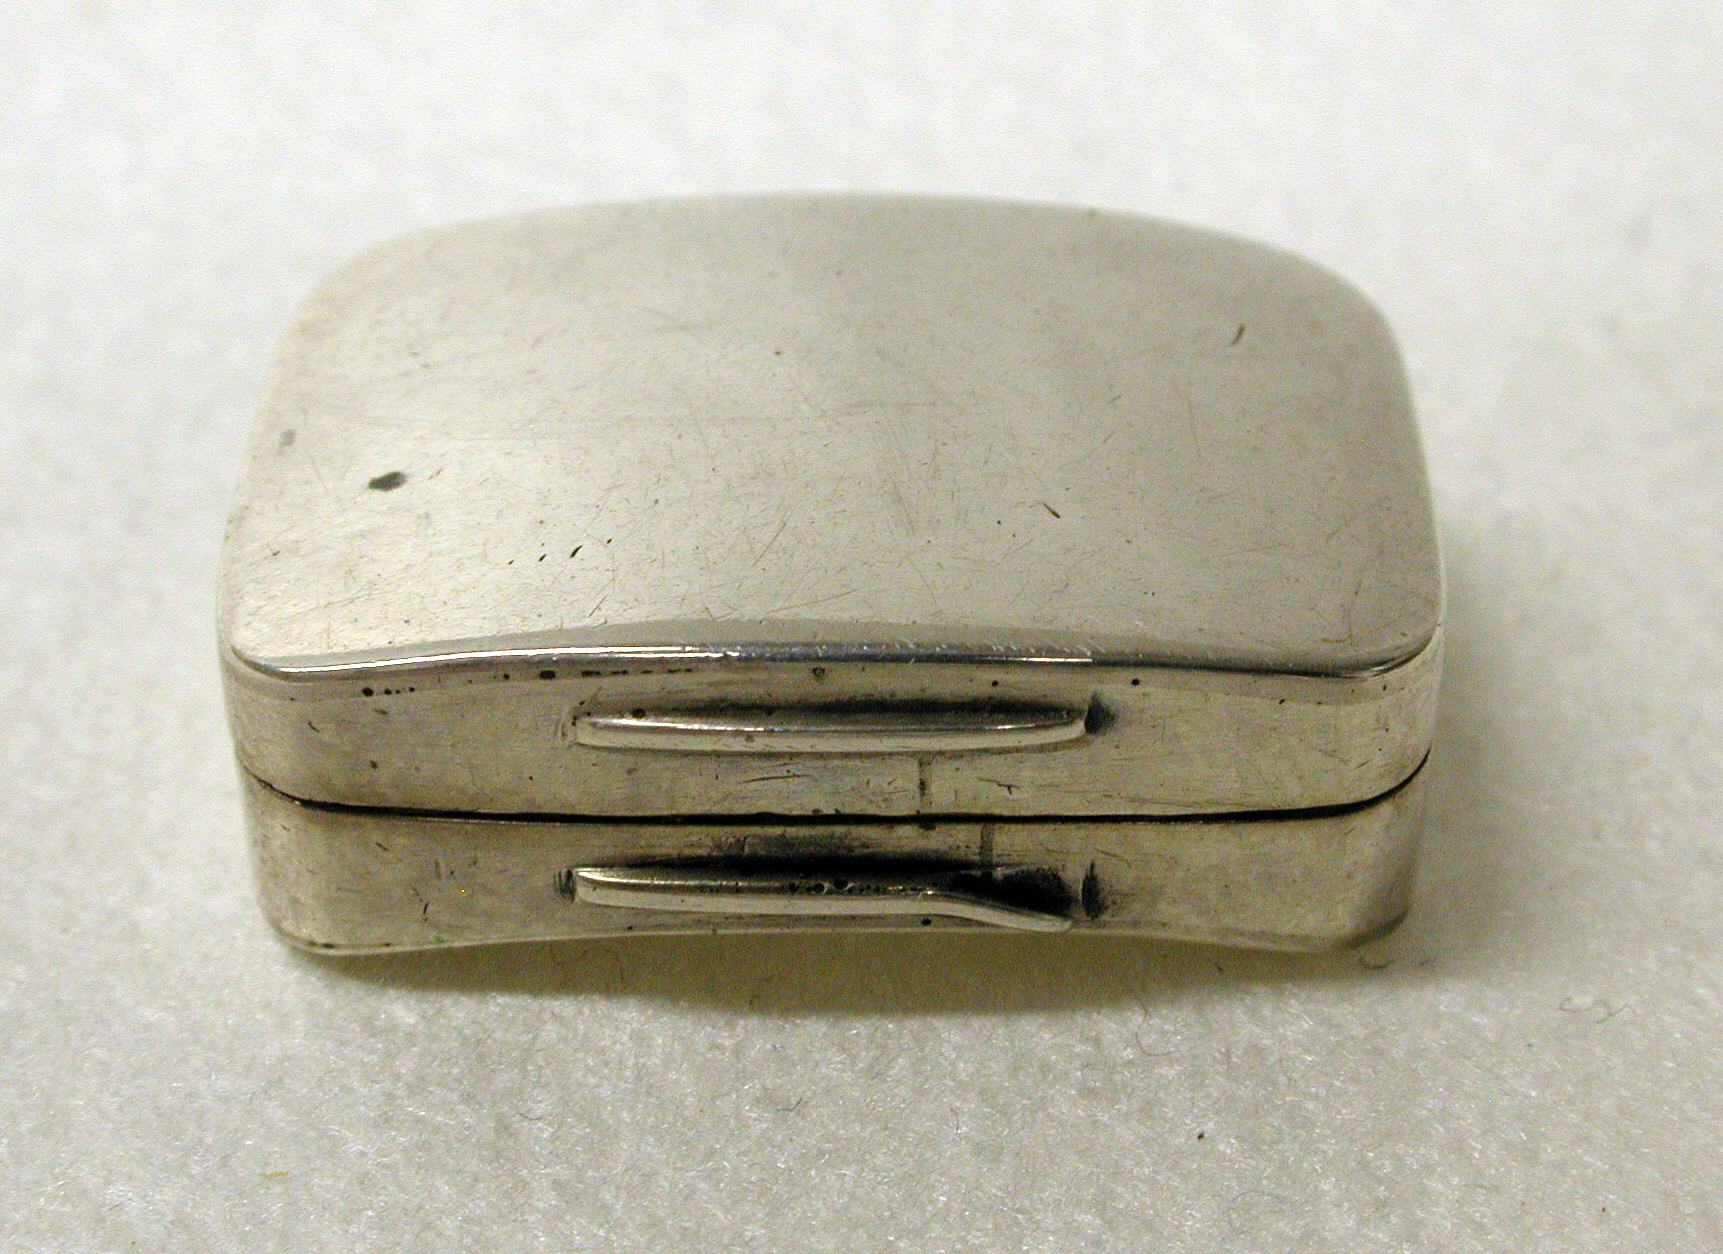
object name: vinaigrette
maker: samuel pemberton iii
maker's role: maker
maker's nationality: british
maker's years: 1771-1836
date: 1806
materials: silver